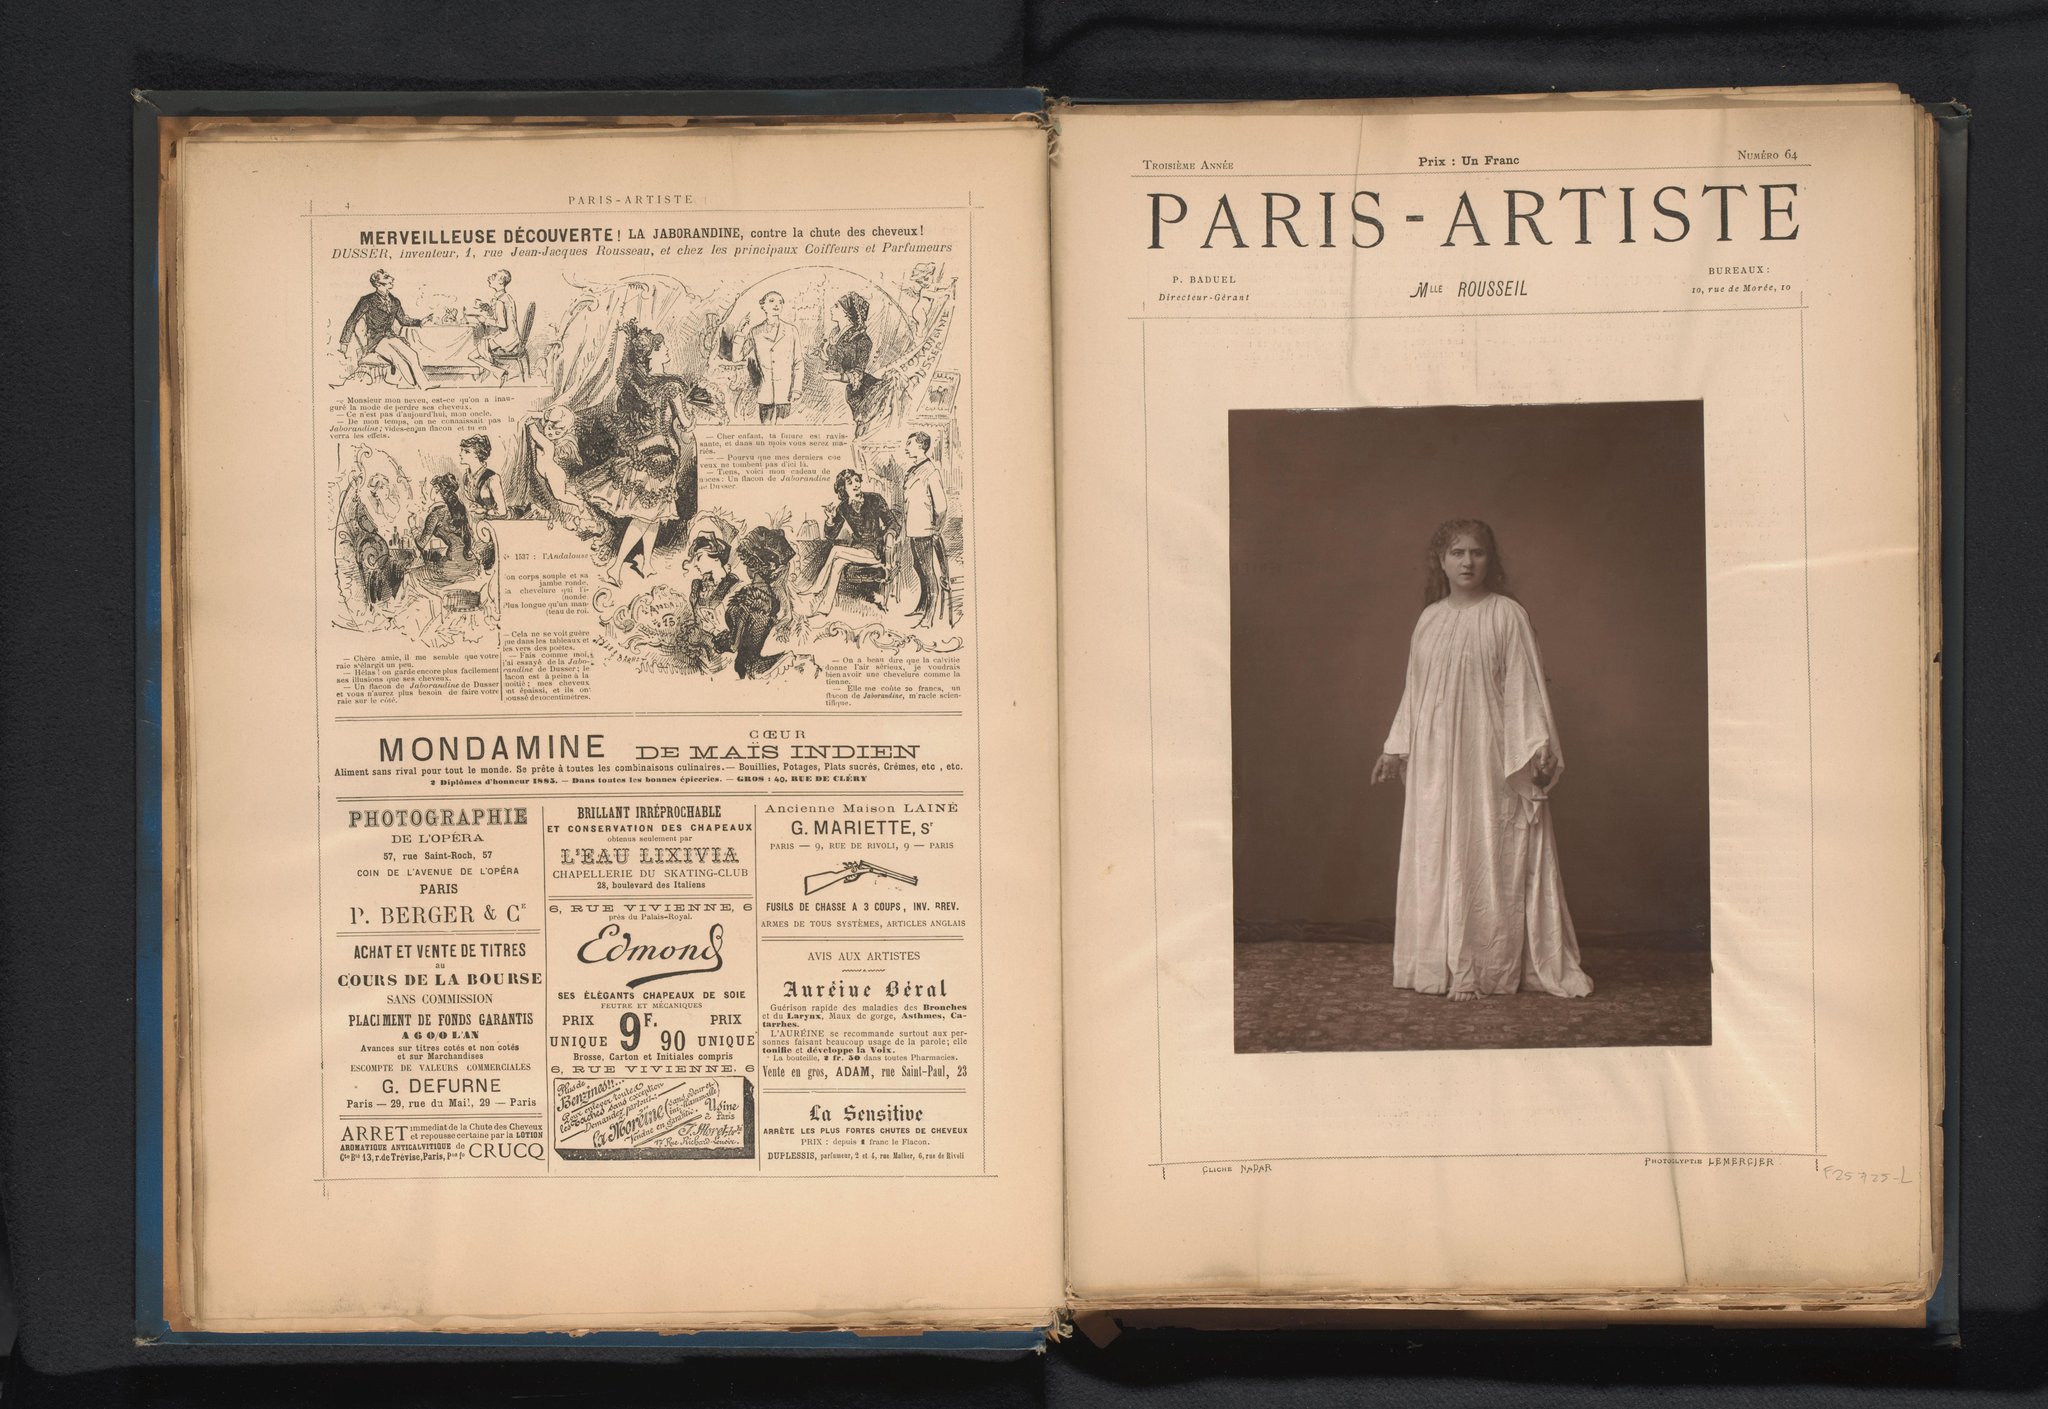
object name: photomechanical print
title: Portret van Rosélia Rousseil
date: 1880-1885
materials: paper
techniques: woodburytype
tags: historical persons - bb - woman, portrait of actor, actress